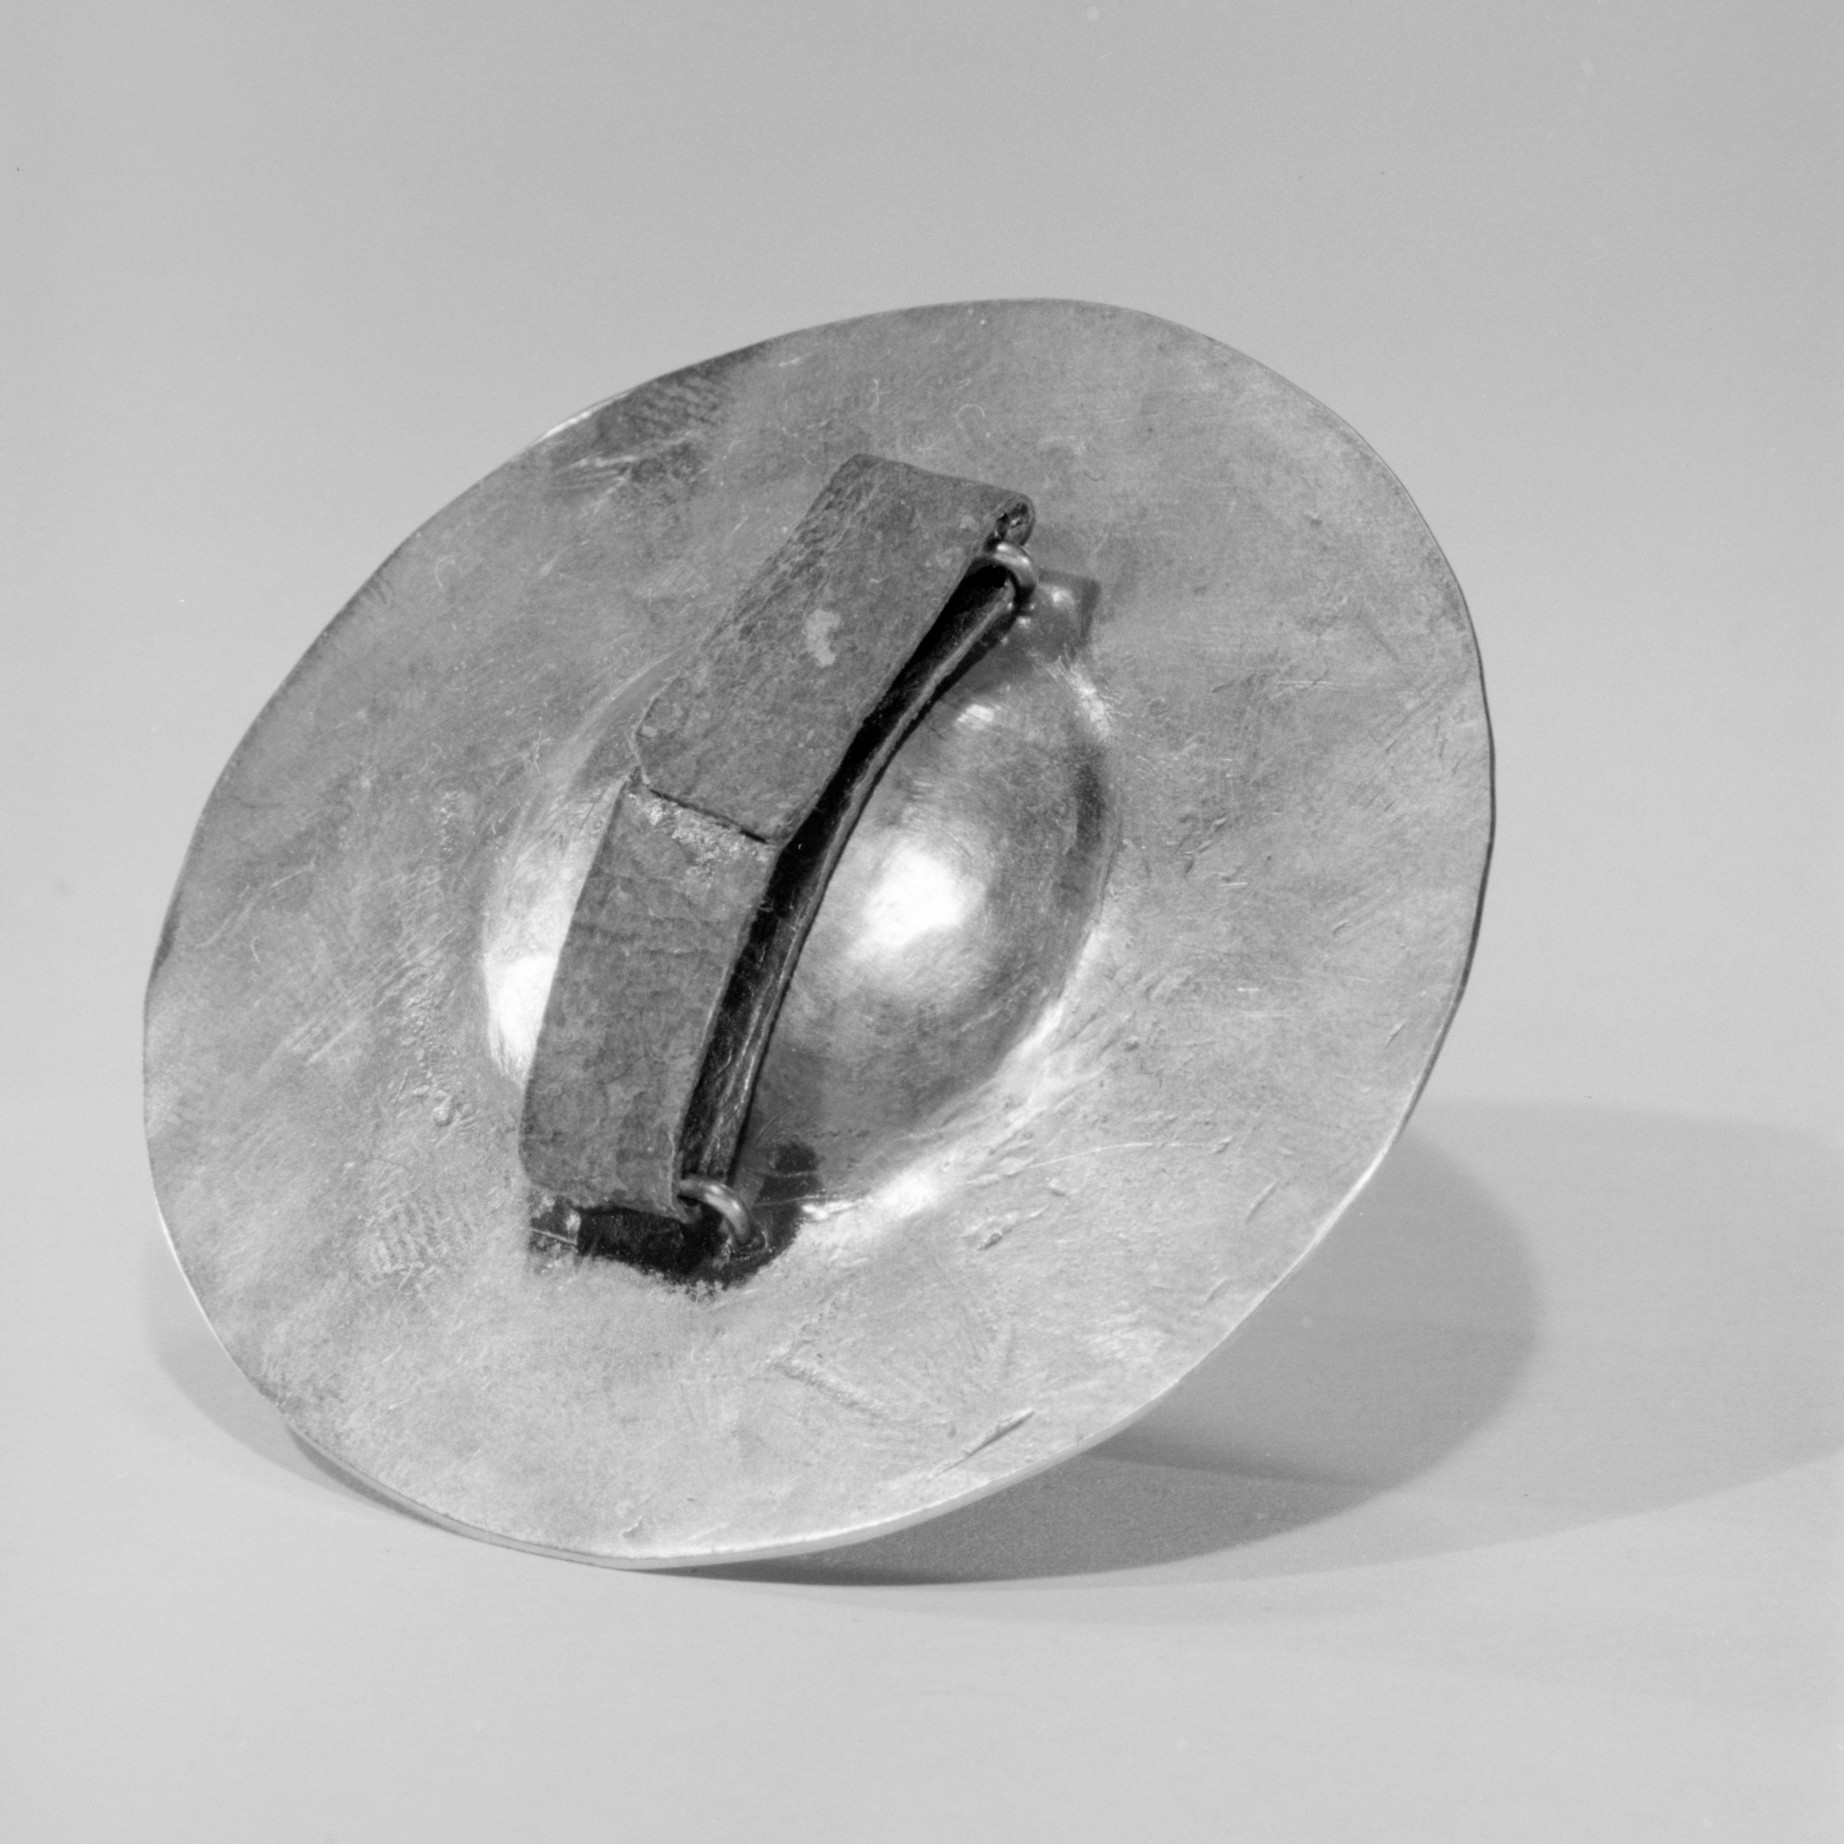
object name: crèche accessory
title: Pair of cymbals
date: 1701-1900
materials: brass, gilt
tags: musical instruments